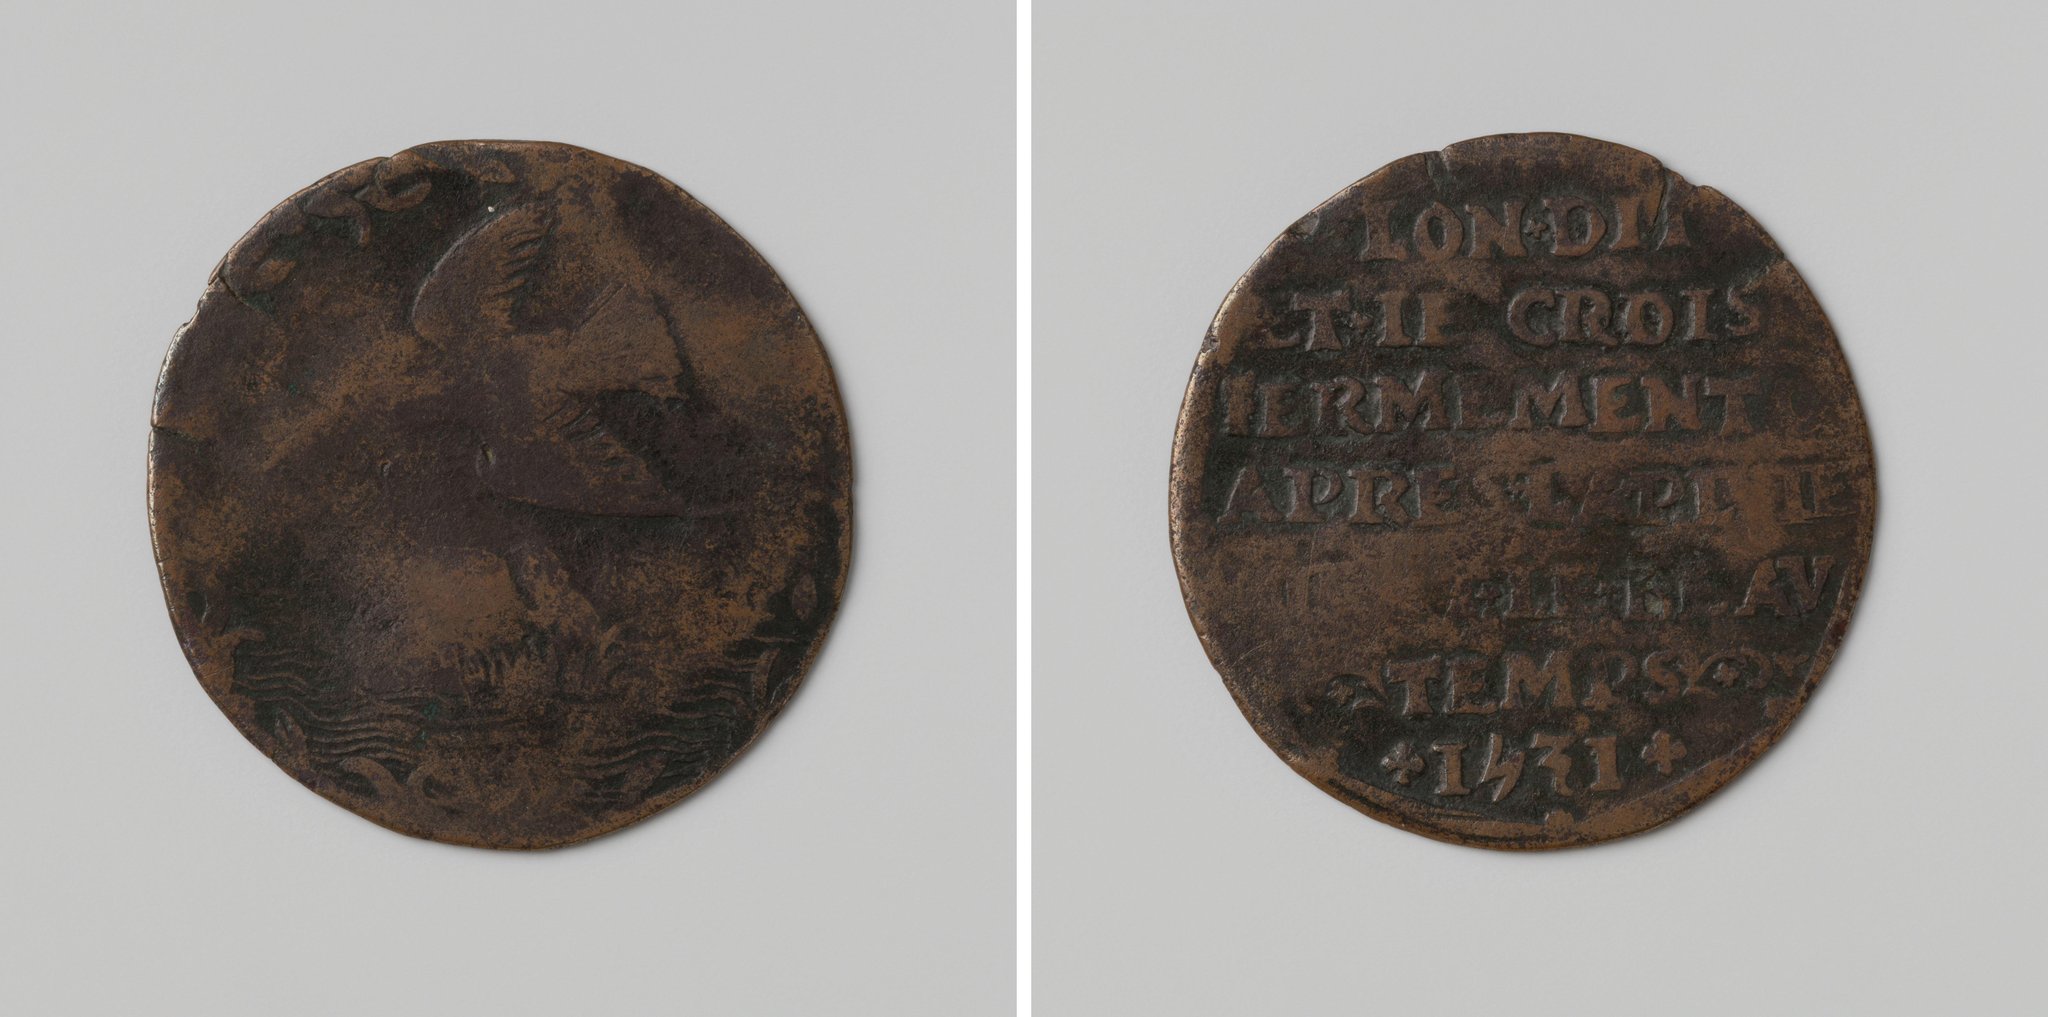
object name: jeton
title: Grote overstroming in Zeeland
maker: Anonymous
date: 1531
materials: copper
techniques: striking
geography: netherlands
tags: zeeland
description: Koperen penning. Voorzijde: duif met olijftak in bek, vliegend boven water binnen bladerguirlande. Keerzijde: opschrift binnen koord met acht knopen